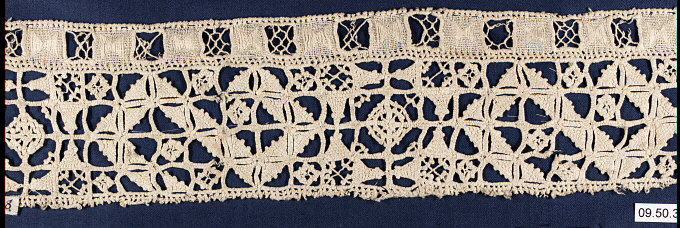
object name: strip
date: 1501-1700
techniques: lace